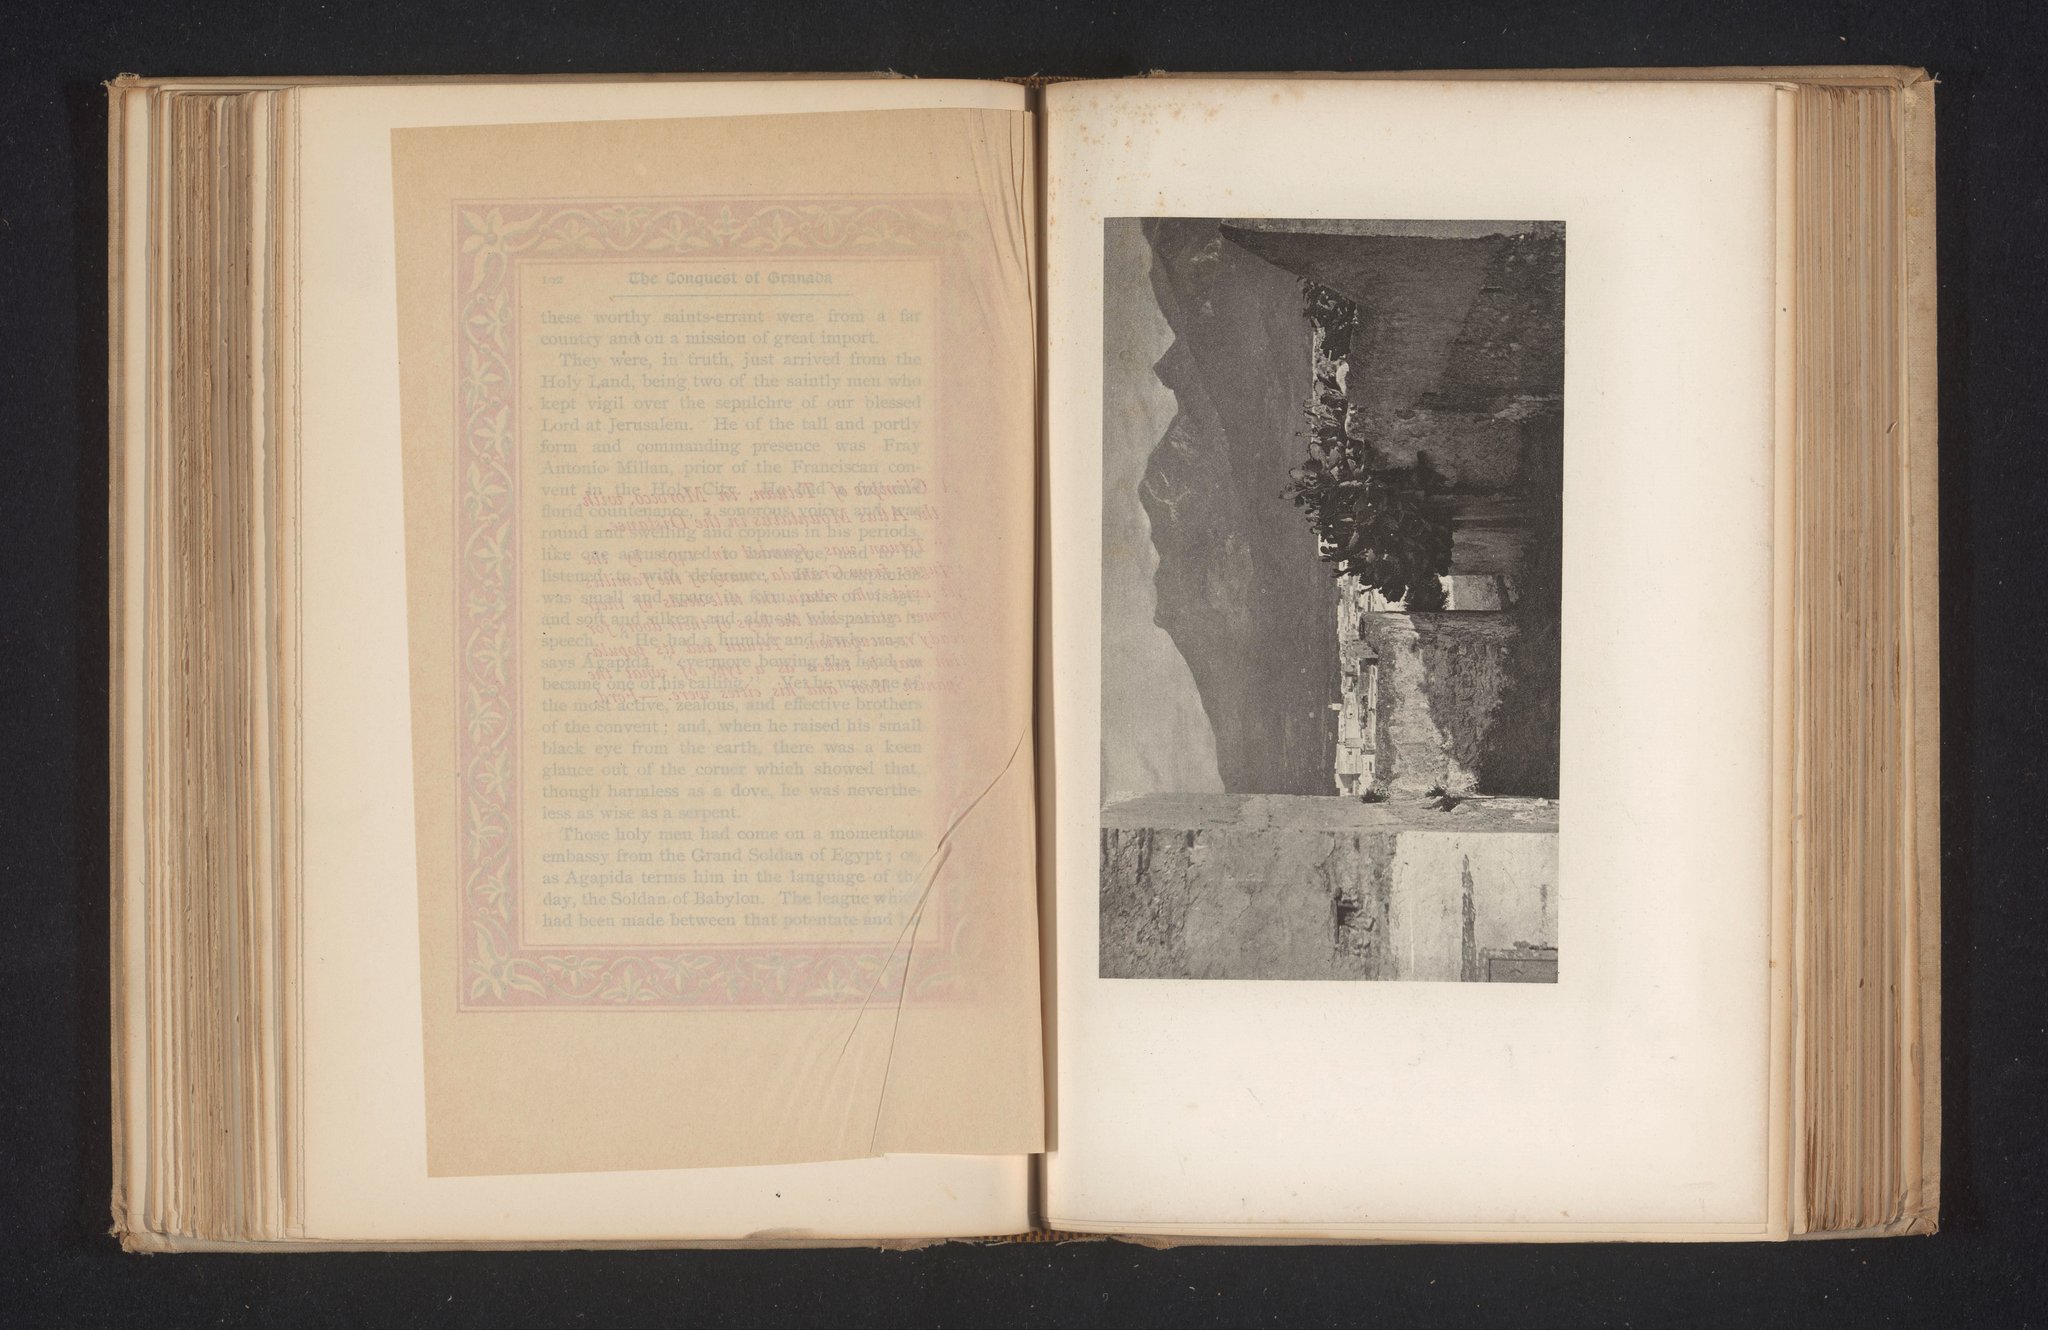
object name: photomechanical print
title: Gezicht op Tétouan en het Rifgebergte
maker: Anonymous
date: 1883-1893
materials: paper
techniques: photoaquatint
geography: andalusia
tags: mountains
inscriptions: inscription: ‘“ Tetuan was founded in 1492 by the refugees from Granada; [...] ” Ford.’